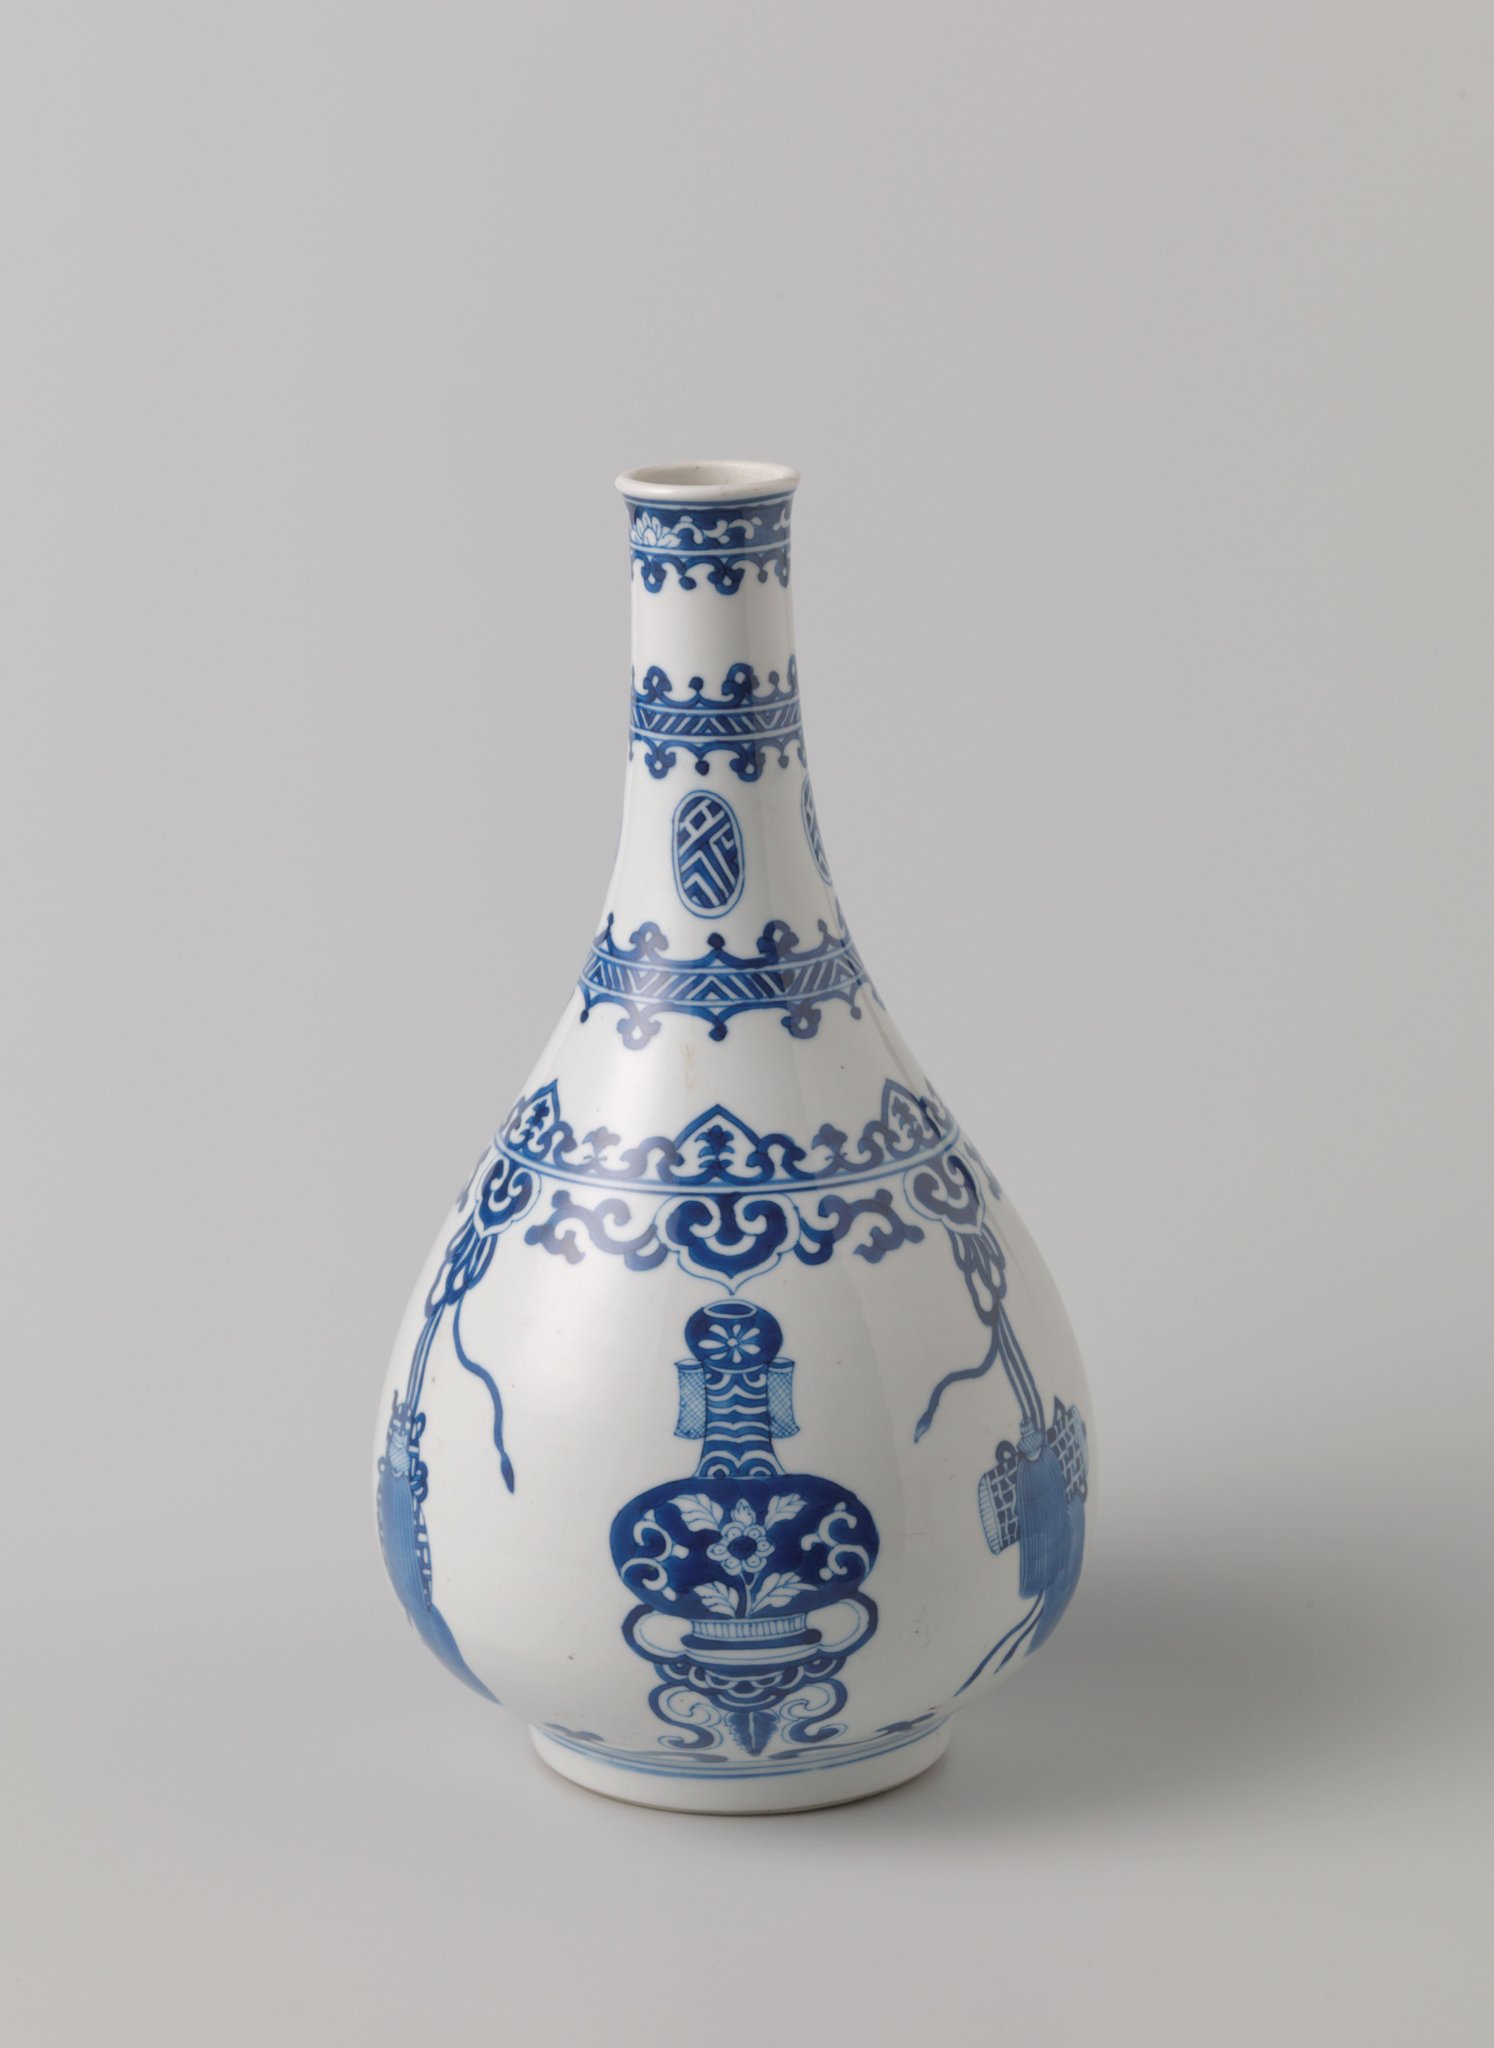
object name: vase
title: Pear-shaped bottle vase with auspicious symbols, tassels and ornamental borders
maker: Anonymous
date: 1680-1720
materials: cobalt, glaze, paint, porcelain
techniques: firing, turning, vitrification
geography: china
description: AK-NM-6757 Twee vazen • Blauw-wit Kangxi-porselein • Onderdeel van Royers porseleincollectie Dit is eigenlijk een wonderlijke vaas. Waar ik vooral mee zit zijn die horizontale banden. Bij veel Chinees porselein is de organisatie van de beschildering goed te begrijpen: banden, velden, florale motieven lijken op een logische en harmonieuze manier over het oppervlak verspreid. Logisch vanuit het perspectief van de Chinese vormentaal en van eerder geproduceerde typen porselein, of eventueel vanuit het perspectief van begrijpelijke wensen van Europese kopers. Langs die weg kan ik deze vaas echter niet doorgronden. Wat doen die smalle banden met ornament? Die ovaaltjes met swasitka’s? De grote, uit hun context gehaalde, vazen en hangende rollen vind ik ook niet zo’n succes. De enige verklaring die ik kan geven is dat dit een product is van de zich herstellende handel in Chinees porselein aan het eind van de 17de eeuw. Smalle horizontale banden komen al voor op kannen uit de Overgangsperiode [Ayers 2016, vol. I nrs. 233-234]. Precies bestellen wat men hebben wilde, was niet eenvoudig. Goed verkopende stukken werden ongetwijfeld meegestuurd als voorbeeld voor de volgende zending, mét aanwijzingen: dit decoratieve element wat meer, dat wat minder. Blijkbaar was het porselein met horizontale banden uit de Overgangsperiode wel een succes geweest, want in het Kangxi-porselein zijn meer (niet zo erg geslaagde) voorbeelden aan te wijzen van een voortzetting van die manier van beschilderen. Het moet zijn verdwenen toen het evenwichtiger, zogenaamde Marot-porselein, met ruyi- of lambrequin-ornamenten ruim voor handen was. Toch moeten deze vazen een groot succes zijn geweest. Alleen al in de Rijksmuseumcollectie zijn stellen van deze vazen uit drie verschillende collecties aanwezig [Jörg 1997, nr. 103]. In de collectie van het Topkapi-museum bevinden zich er 13 [Krahl en Ayers 1986, Vol. III, nrs. 2158-2159] en ze worden ‘atijd’ aangeboden door handelaren en veilinghuizen [Berwald, Van der Ven]. Op het schilderij ‘De Spilpenning’ van Cornelis Troost (1741) is de vaas ook te zien (in de schaduw van de rokken van de hoofdpersoon). Zie voor ‘De Spilpenning’ de toelichting bij AK-NM-6839. Troost koos zijn rekwisieten niet zomaar. Ook in 1741 was dit een bekend en gewaardeerd type Chinees porseleinen vaas. Misschien ligt het gewoon aan mij. Bronnen: Regina Krahl en John Ayers, Chinese ceramics in the Topkapi Saray Museum, Istanbul: a complete catalogue, Londen, 1986. Christiaan J.A. Jörg, Chinese ceramics in the collection of the Rijksmuseum, Amsterdam: the Ming and Qing dynasties, Londen, 1997. Amazing blue & white. Cat. Vanderven and Vanderven Oriental Art, Den Bosch, 2011. Summer exhibition of Kangxi porcelain. Cat. Berwald Oriental Art, Londen, 2014.